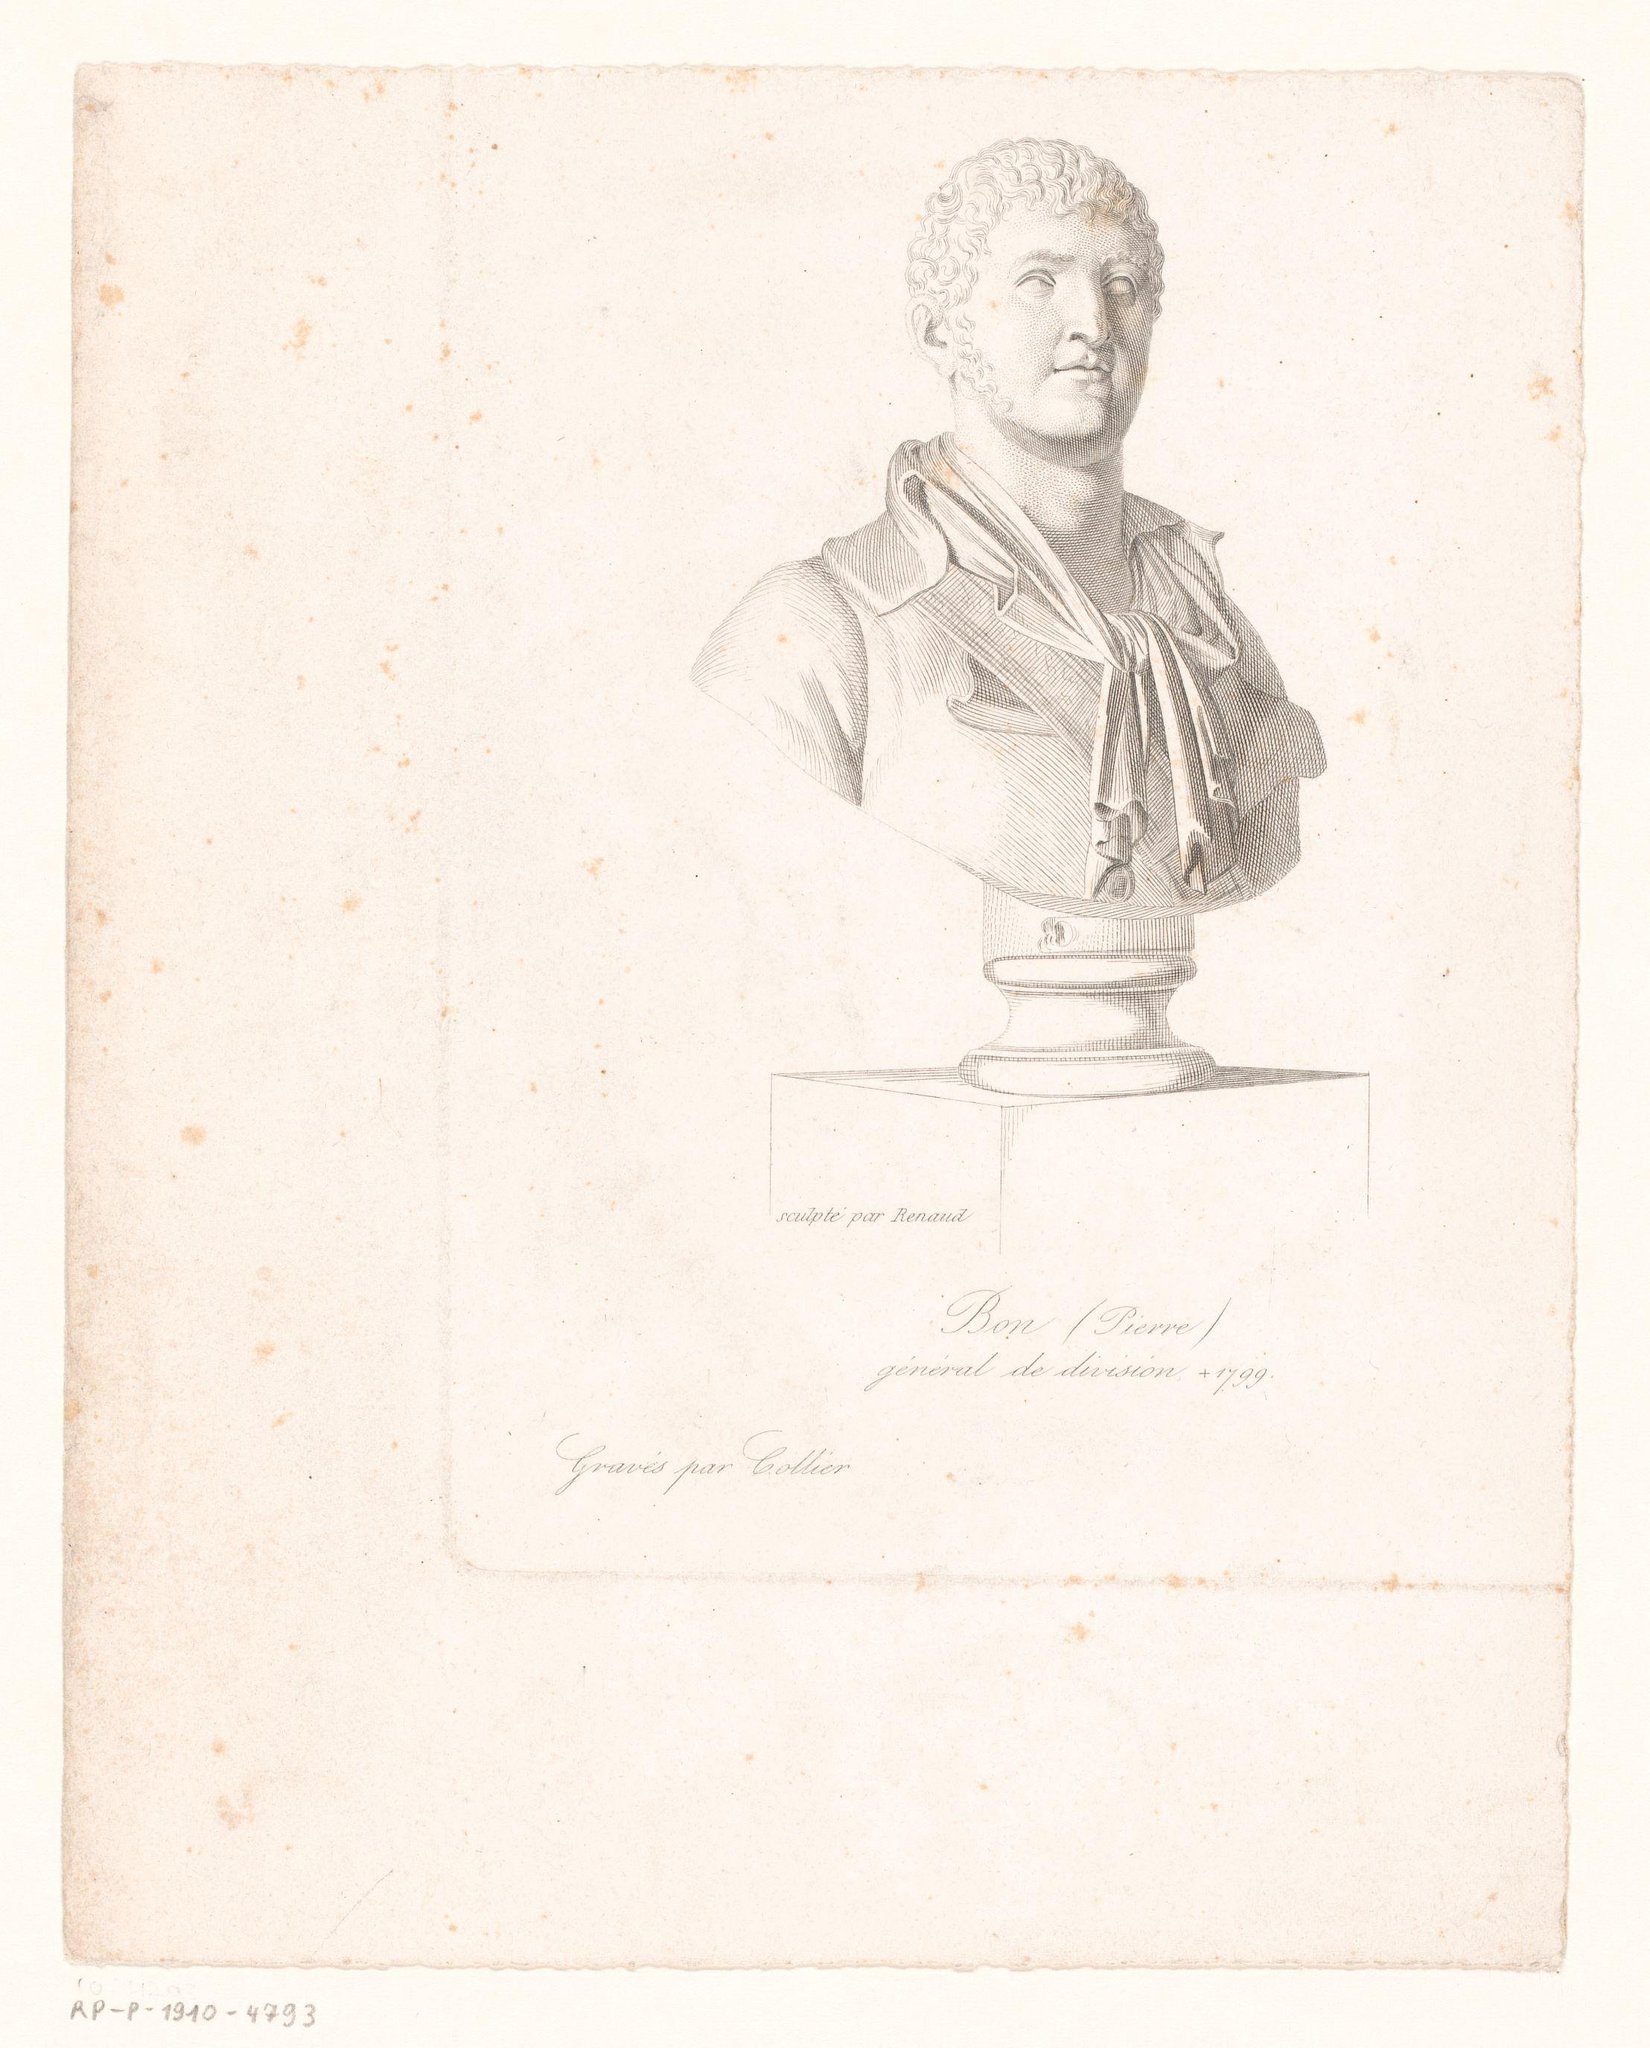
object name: print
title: Portret van Pierre Bon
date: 1828-1910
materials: paper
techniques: etching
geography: france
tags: historical persons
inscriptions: collector's mark: Lugt 2228